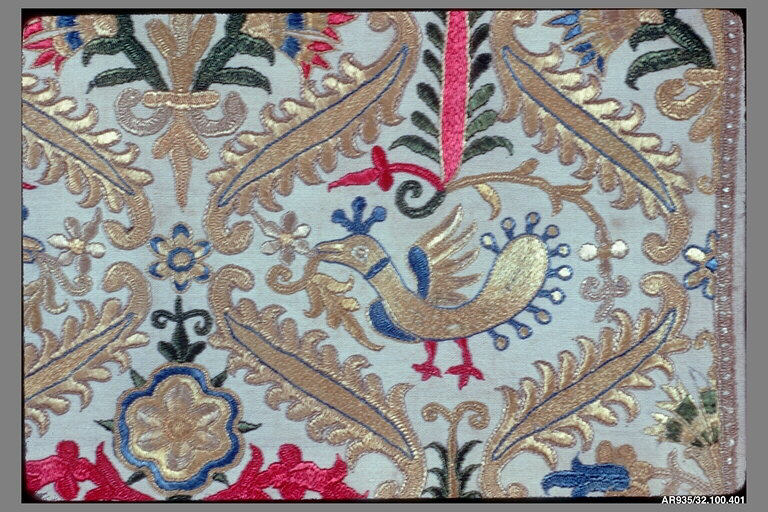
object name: pillow cover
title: Half of a pillow cover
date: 1701-1800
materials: linen, thread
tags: birds